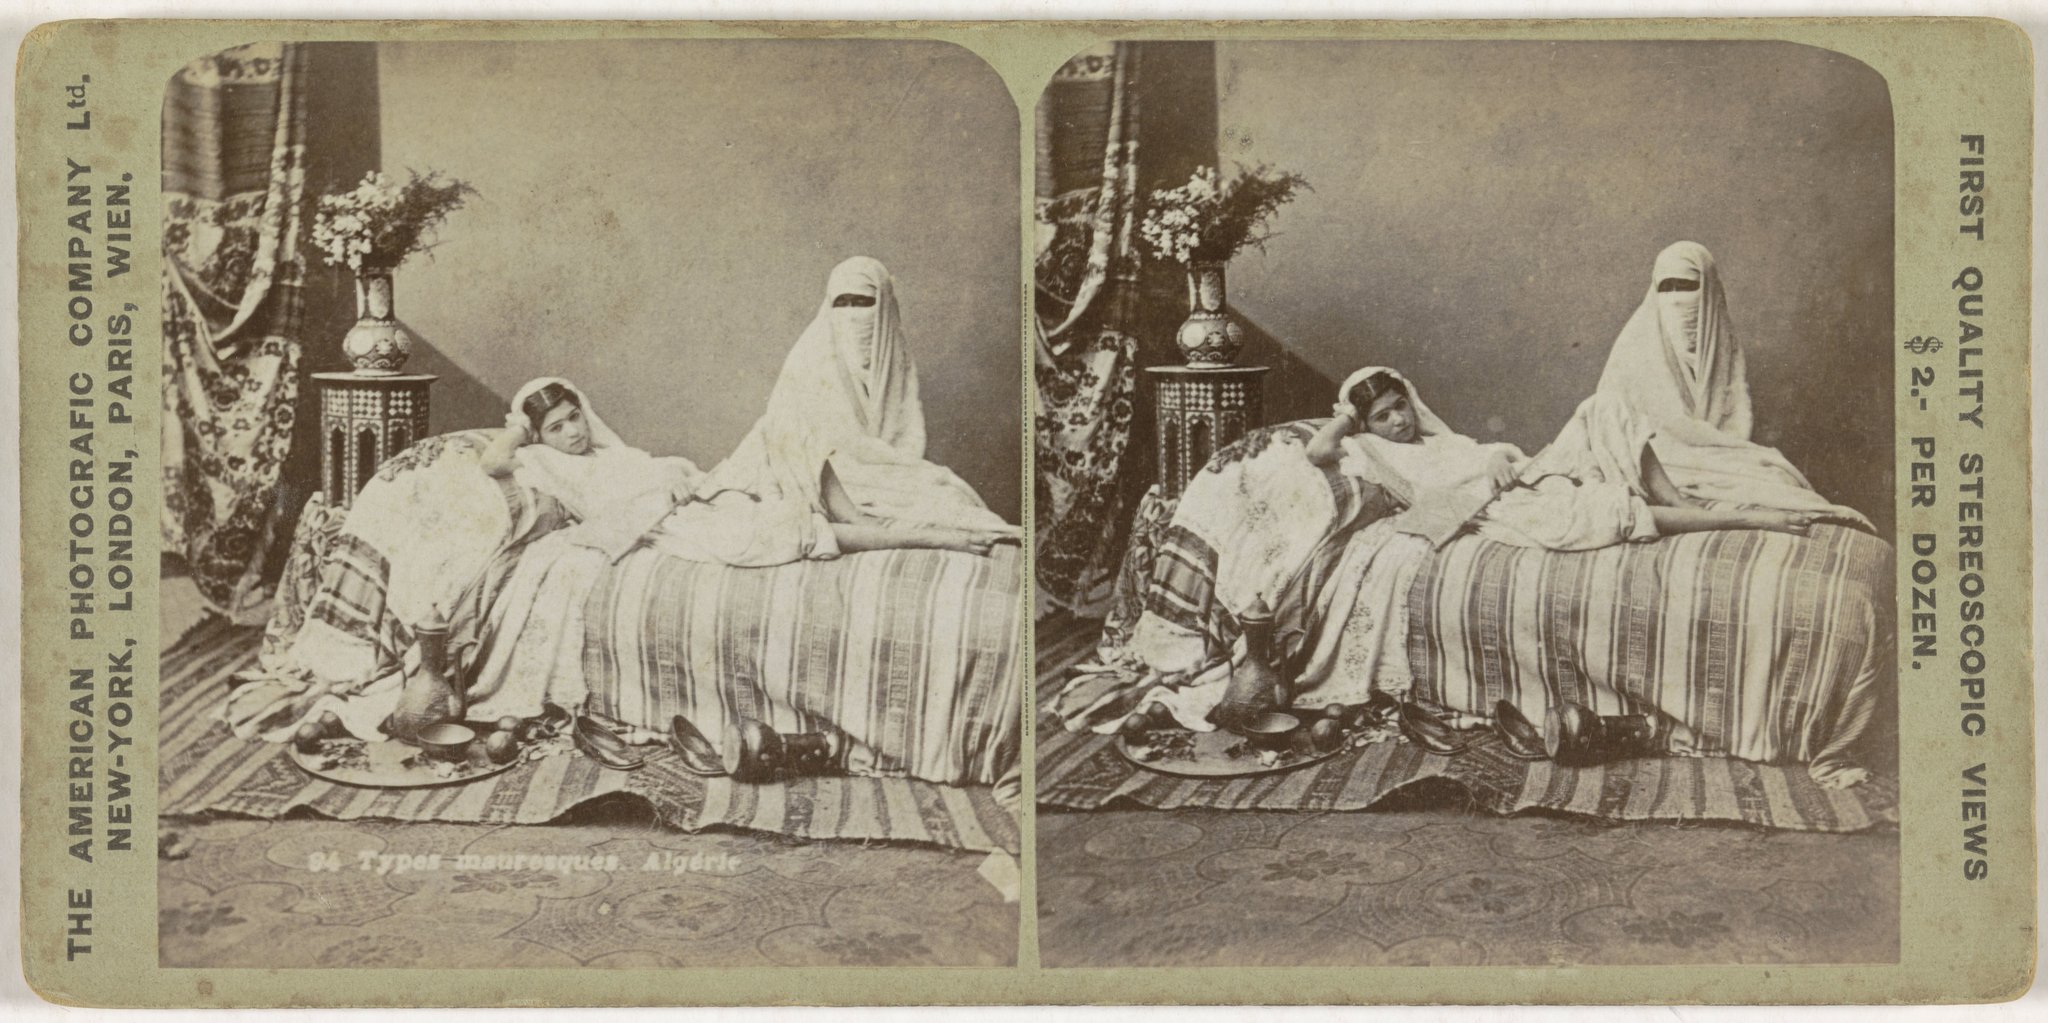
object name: stereograph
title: 84 Types mauresques. Algérie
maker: Anonymous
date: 1860-1870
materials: cardboard, paper, photographic support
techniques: gelatin silver print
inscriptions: number: ‘20 / 00000’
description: Op het karton waar de foto's op zijn geplakt staat aan de rechterkant: First quality stereoscopic views $2.- per dozen.